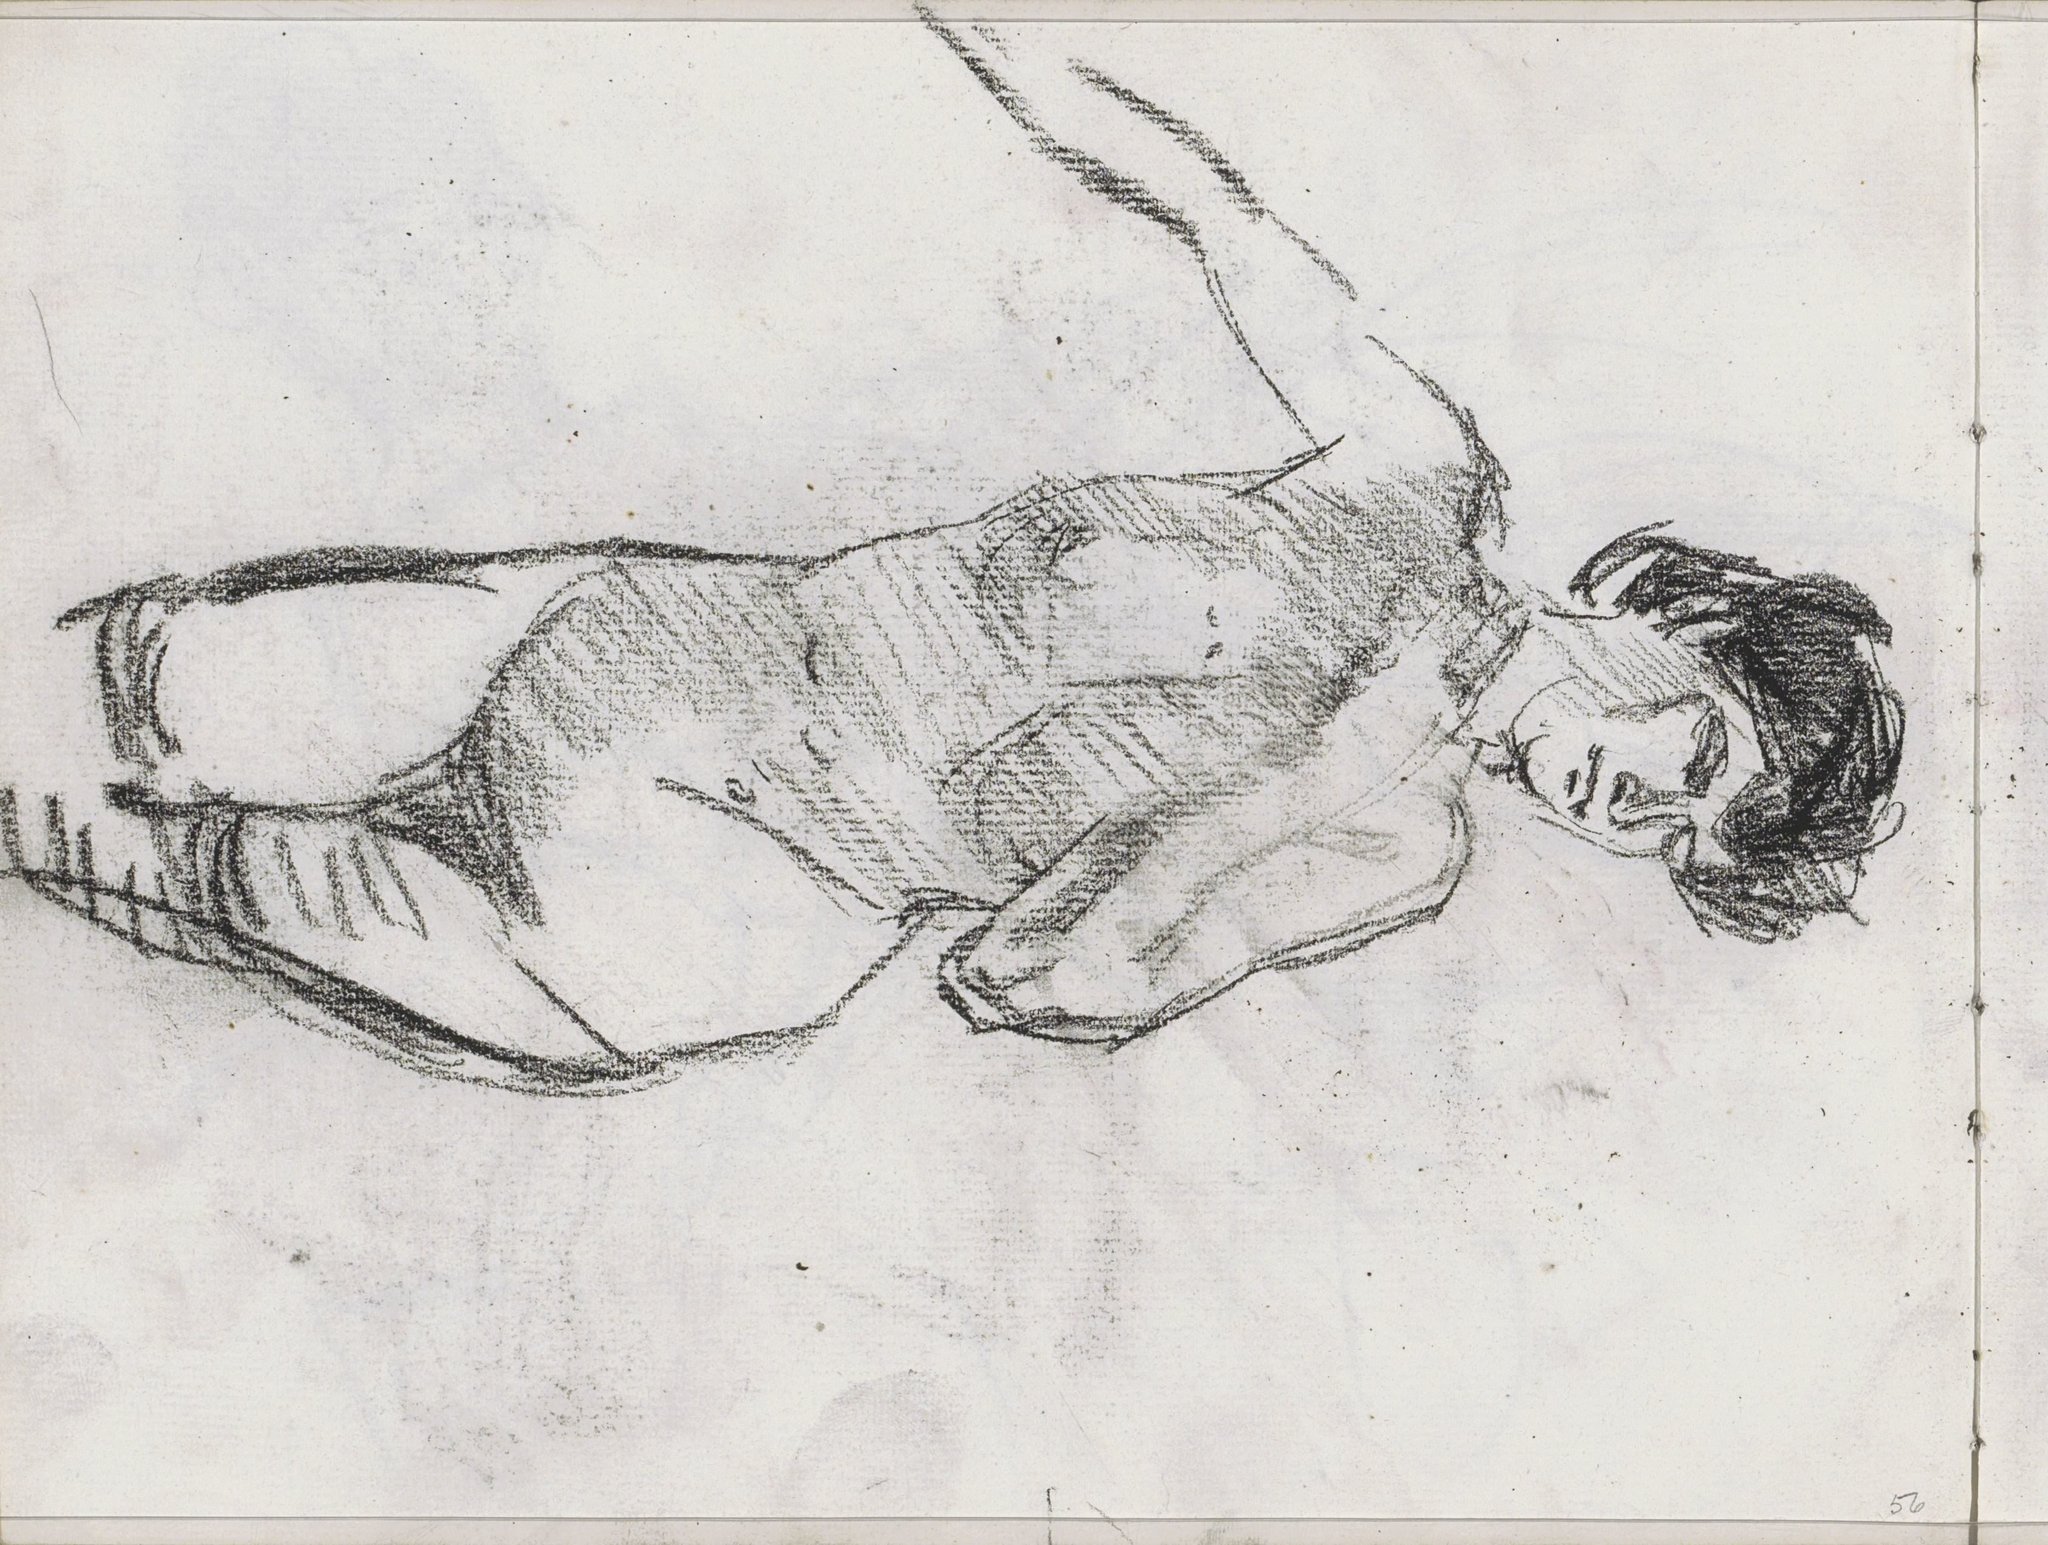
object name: sketchbook leaf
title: Standing Female Nude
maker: isaac israels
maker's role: draughtsman, painter, print maker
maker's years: 1865-1934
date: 1875-1934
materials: chalk, paper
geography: the hague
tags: the (nude) human figure; 'corpo humano' (ripa) - aa - female human figure (+ standing)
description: Blad 25 verso uit schetsboek XXII met 30 bladen.